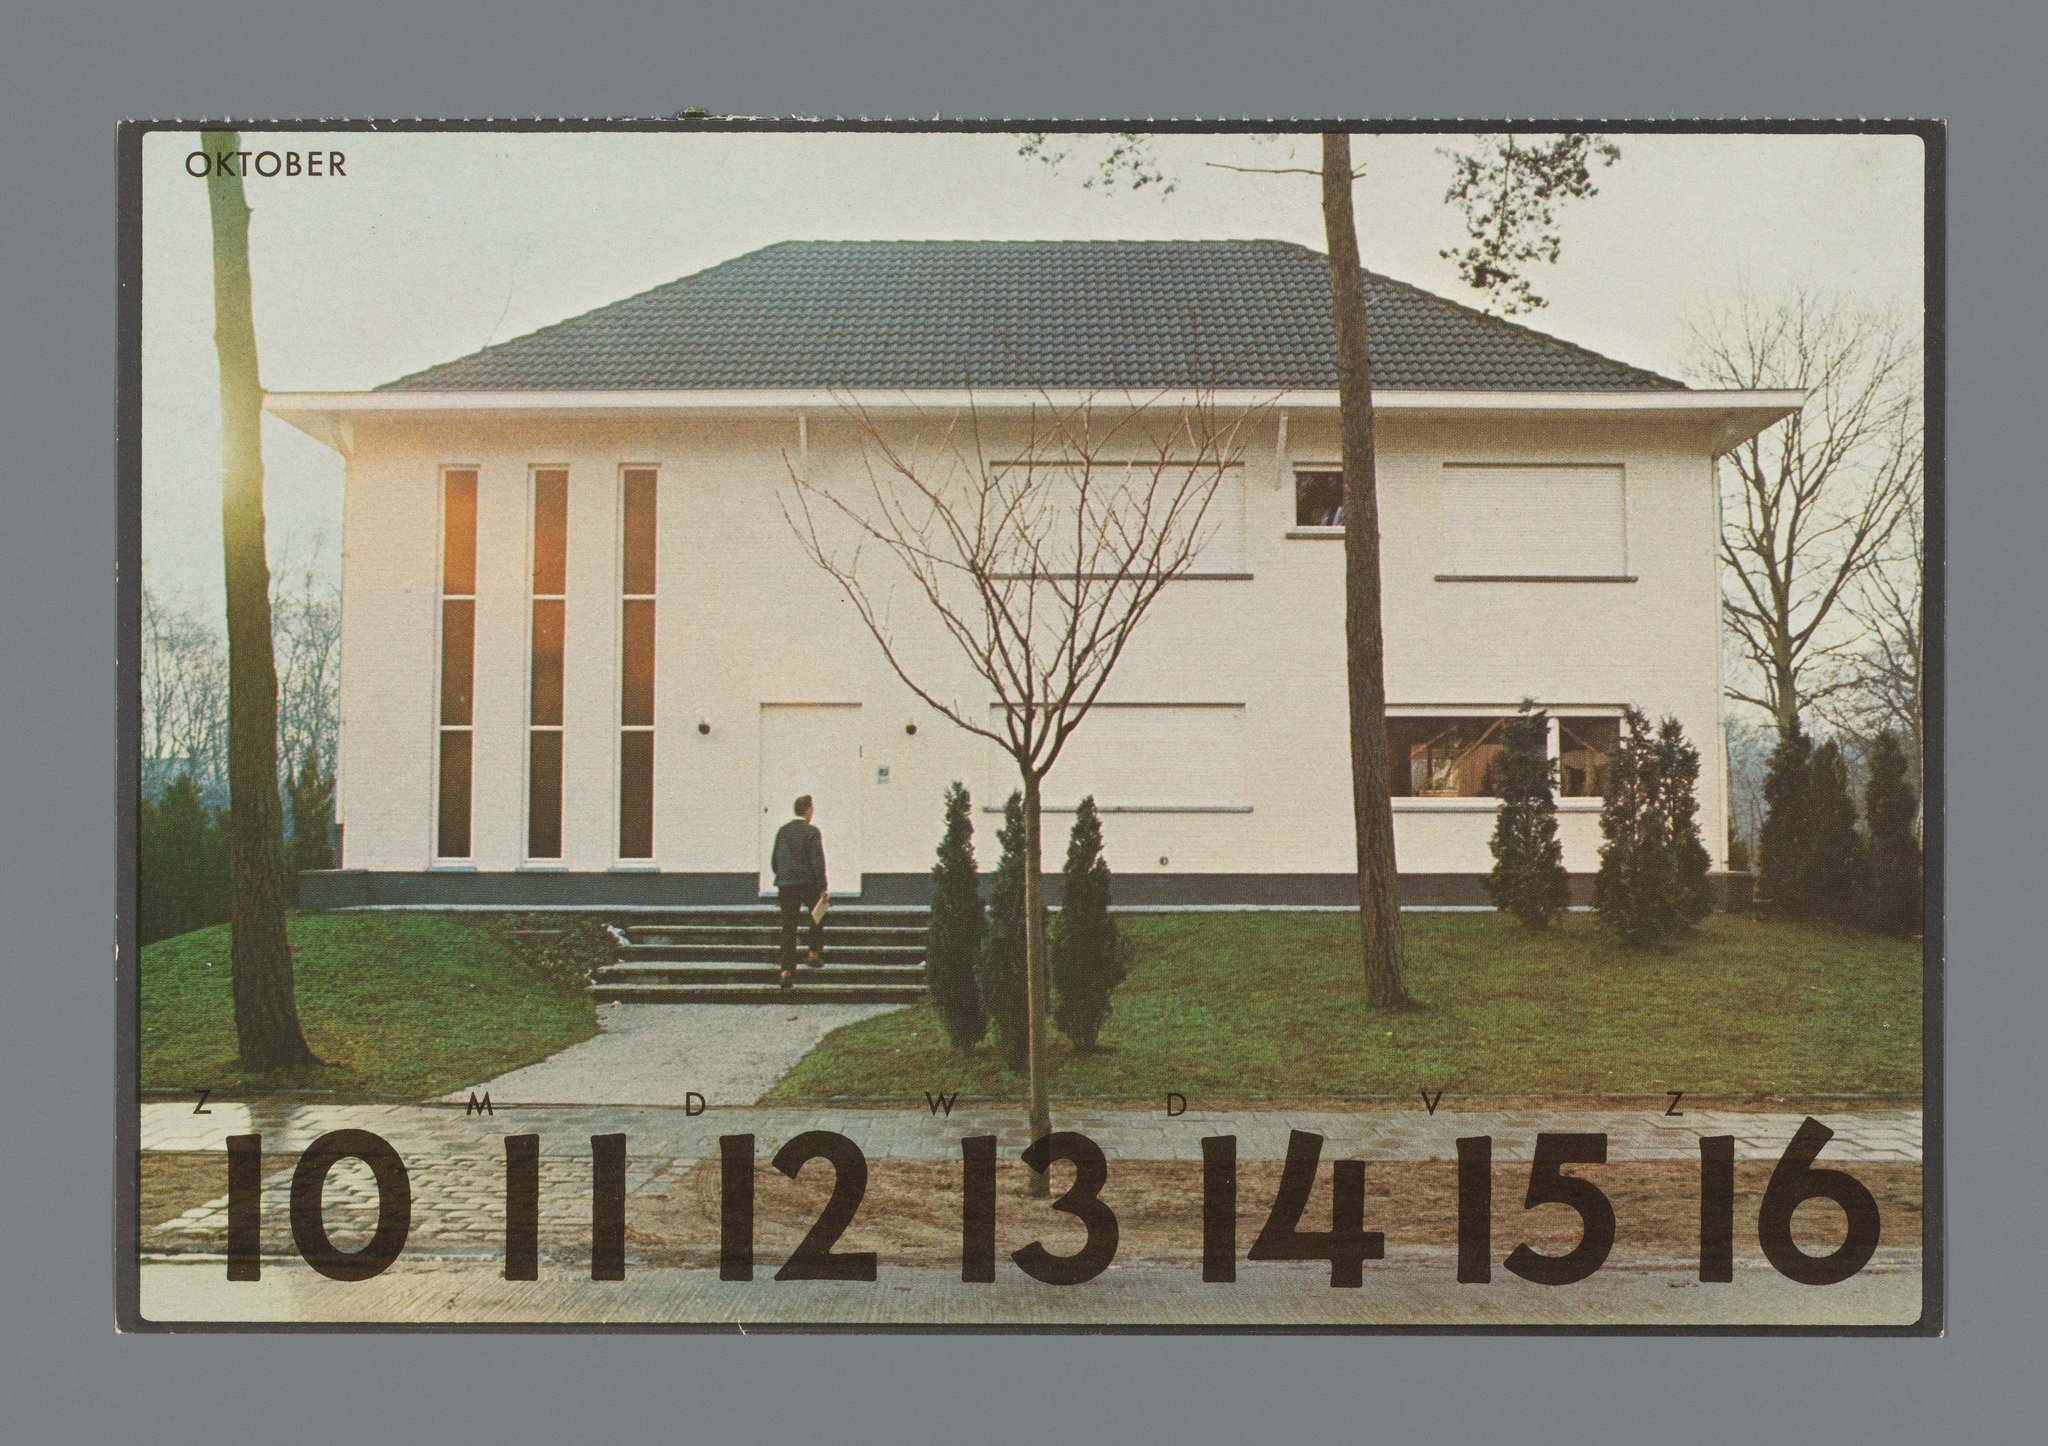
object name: photograph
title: België. Huizen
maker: Anonymous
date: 1900-1950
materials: paper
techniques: offset printed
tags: belgium